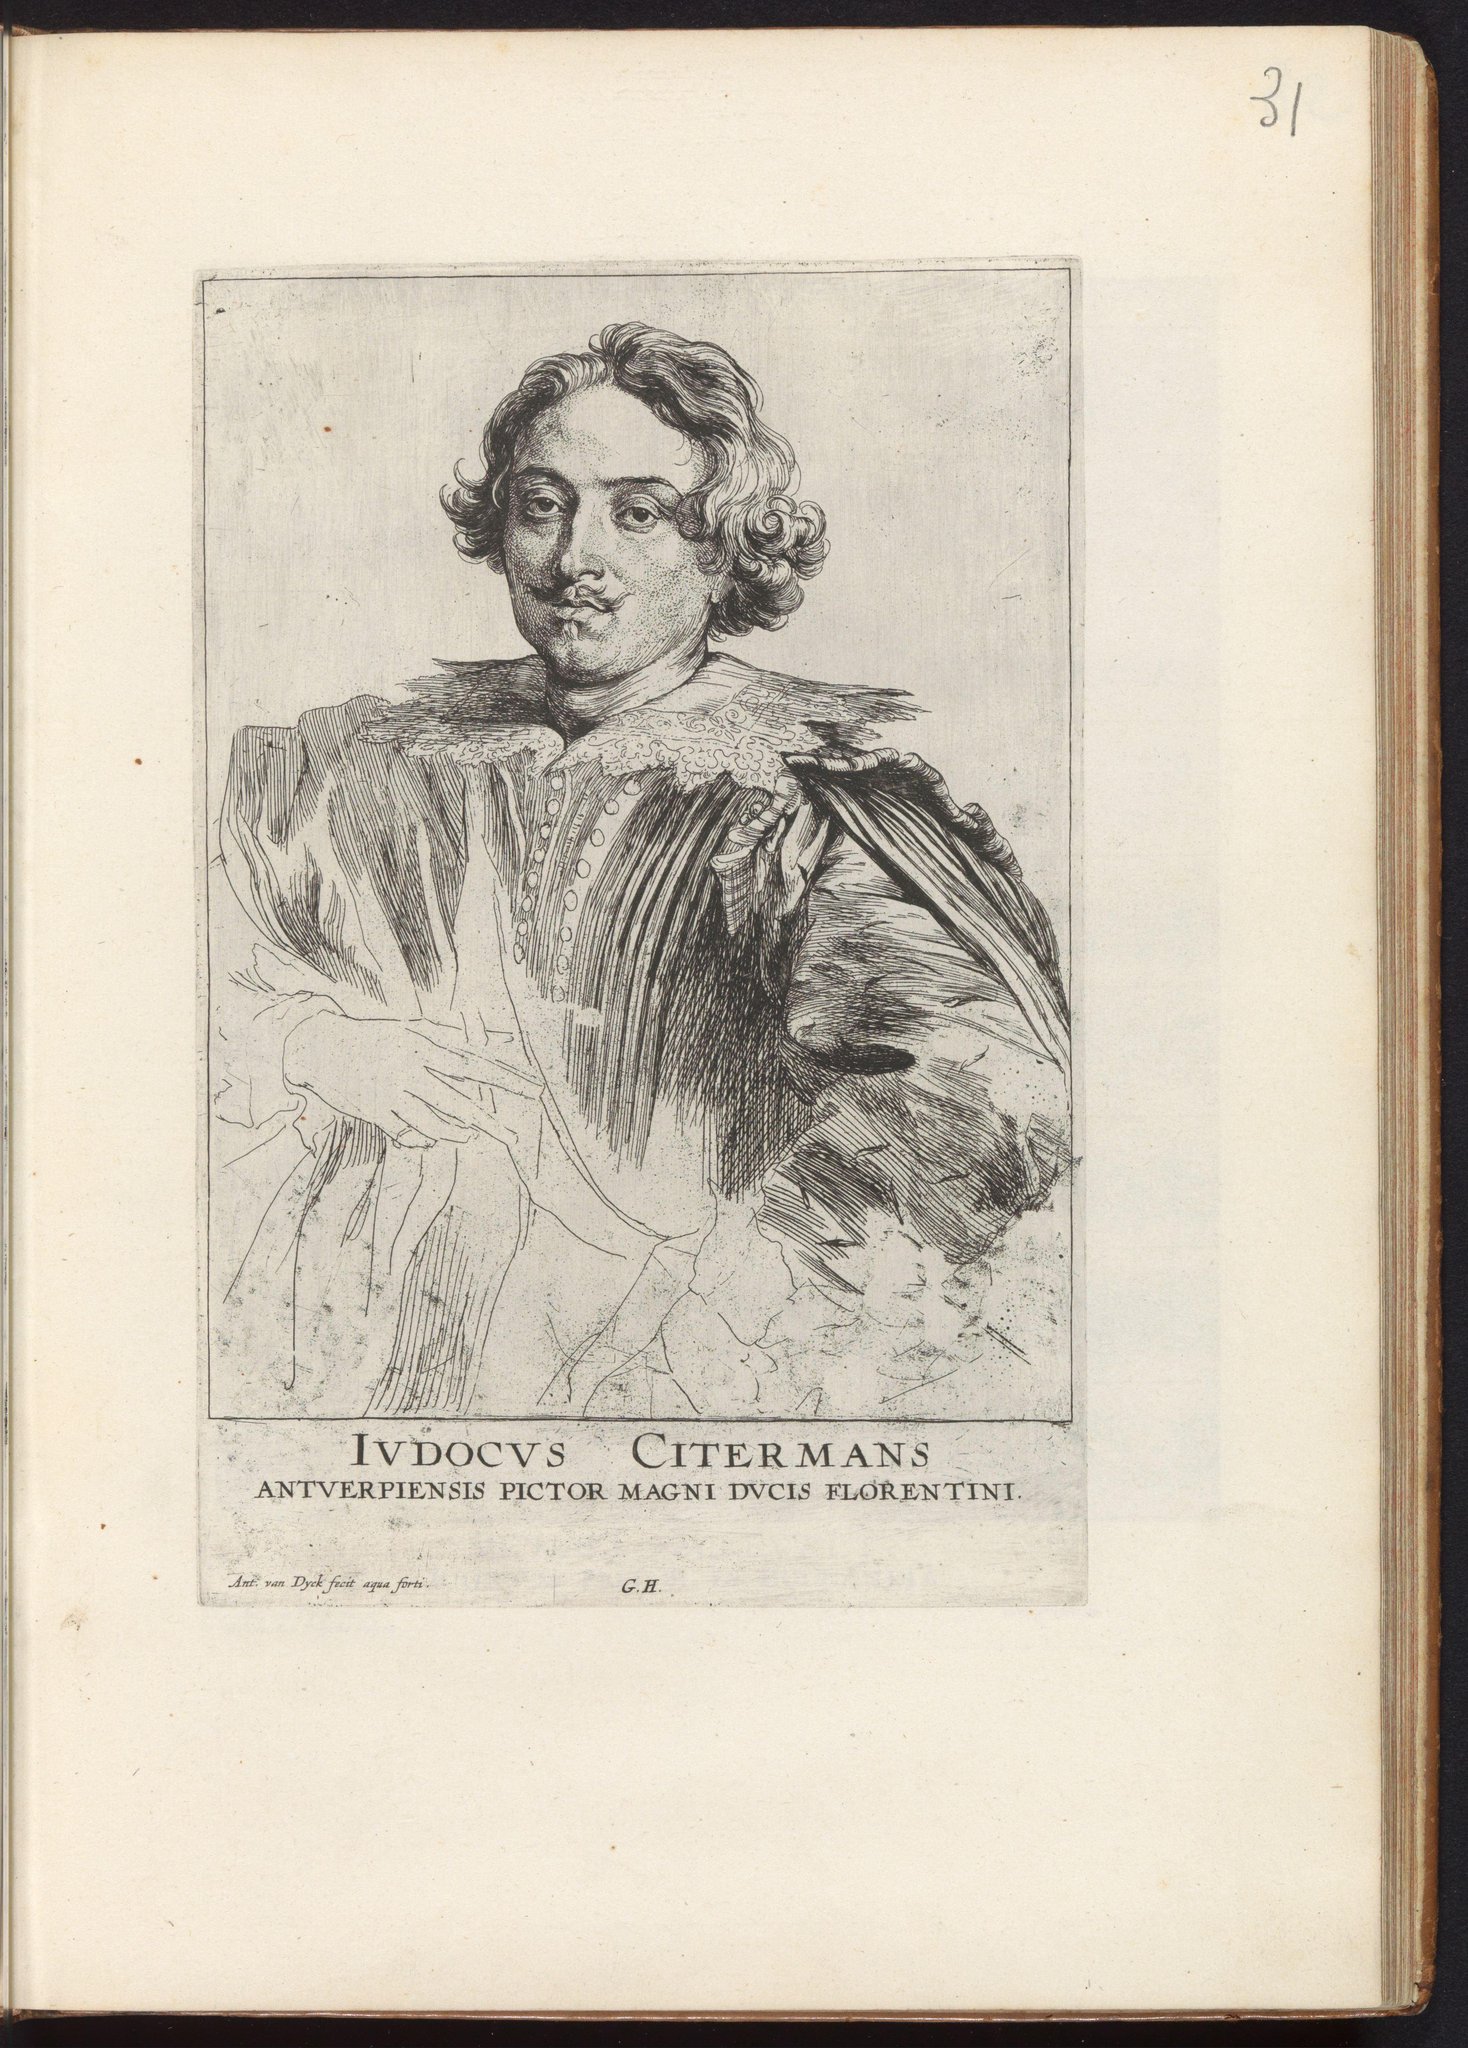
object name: album leaf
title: Portret van Justus Sustermans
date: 1630-1632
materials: paper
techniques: engraving, etching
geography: antwerp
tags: antwerp, painter, draughtsman, justus sustermans, portrait, self-portrait of painter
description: Portret van Justus Sustermans, hofschilder van de familie de Medici te Florence. Deze prent maakt deel uit van een album.